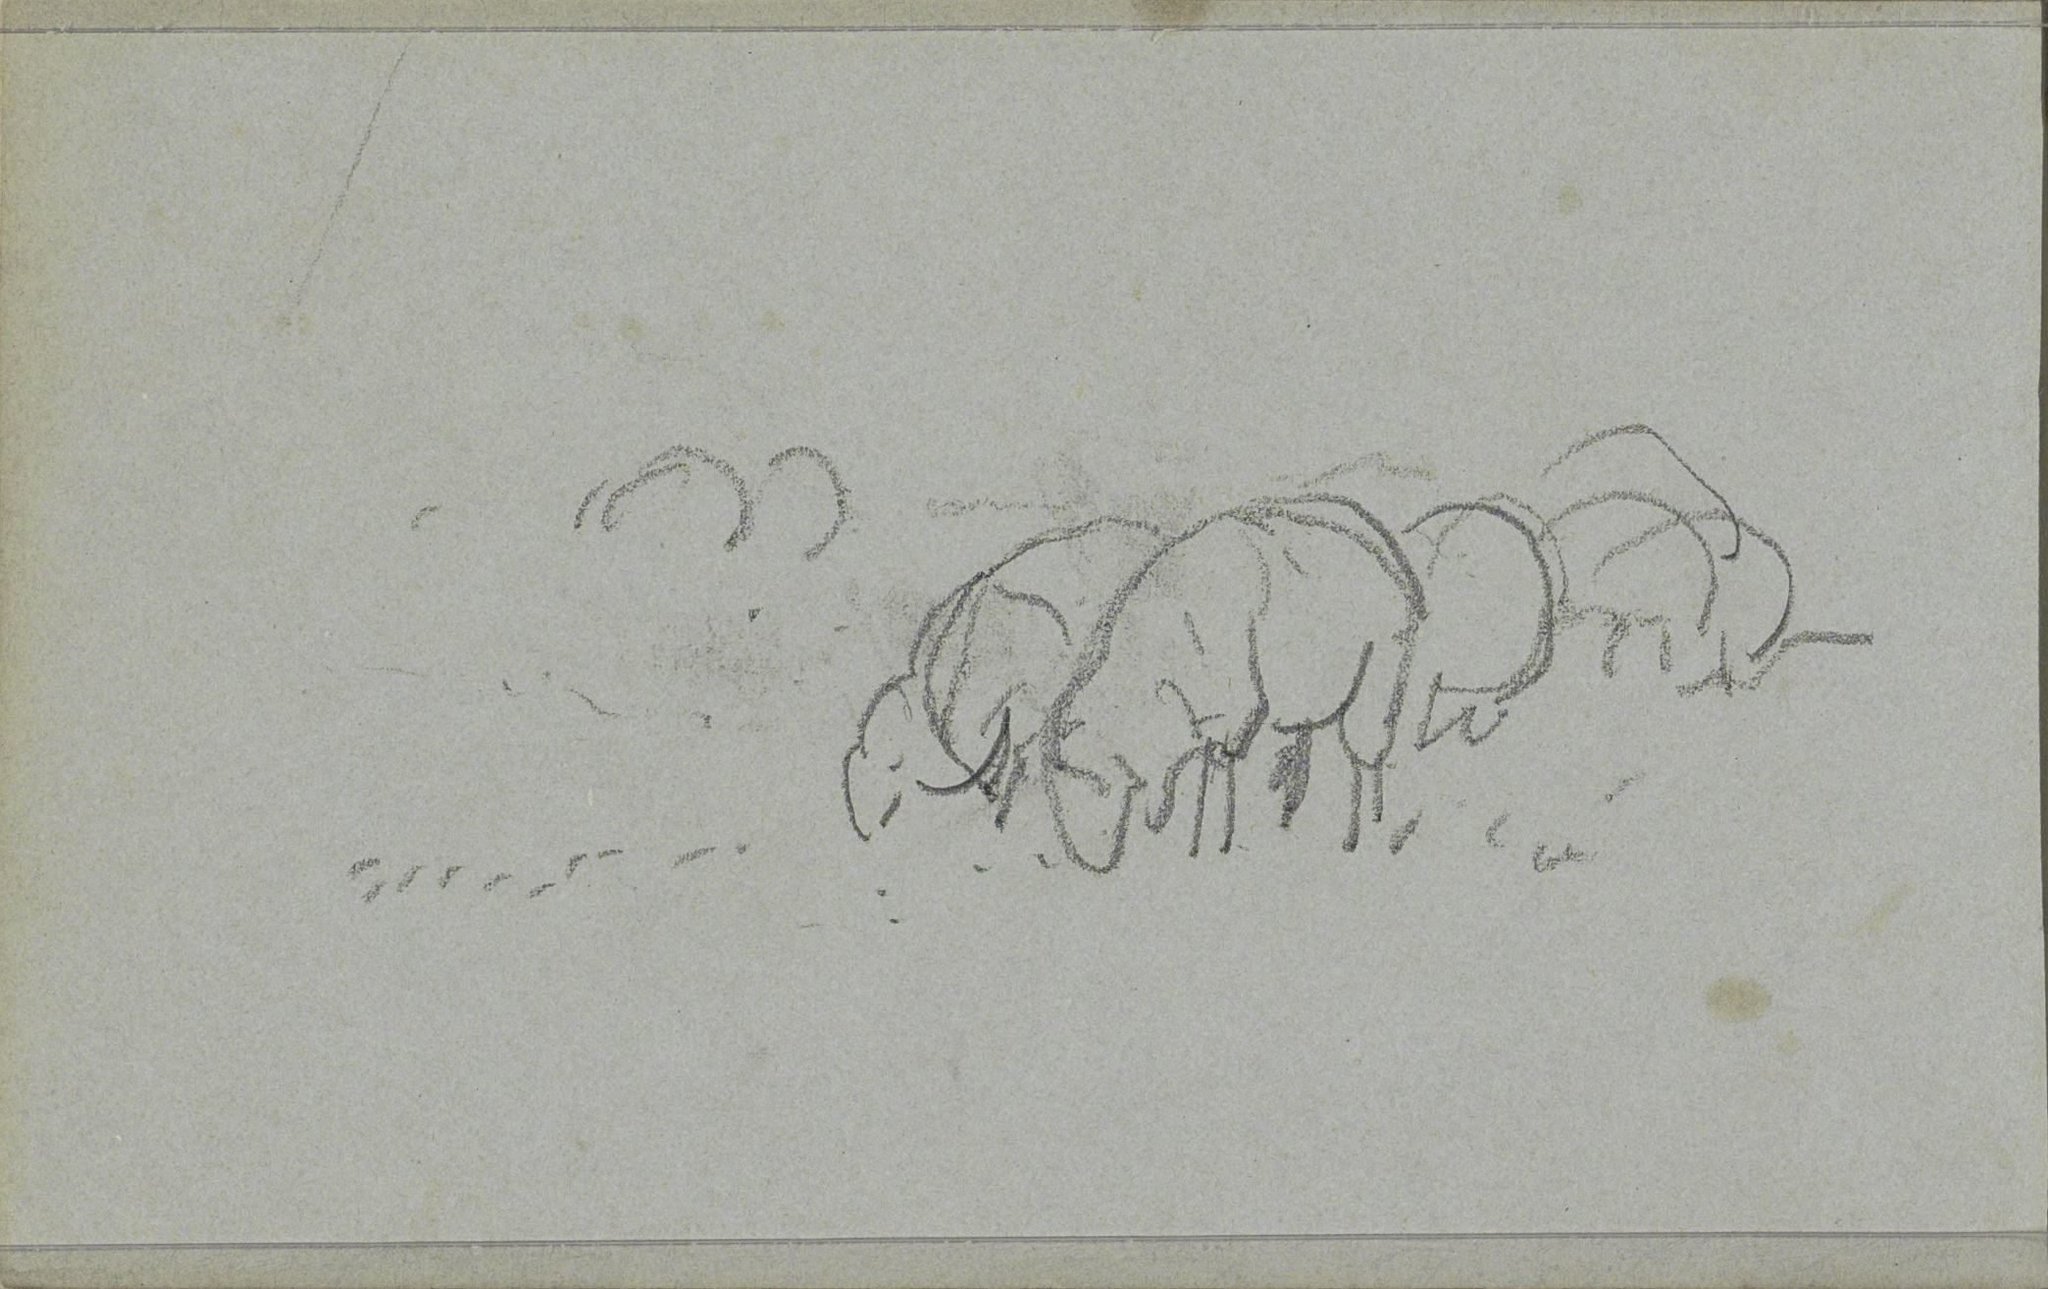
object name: sketchbook leaf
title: Grazende schapen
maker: anton mauve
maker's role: draughtsman, painter, print maker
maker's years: 1838-1888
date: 1848-1888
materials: paper, pencil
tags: sheep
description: Blad 34 verso uit een schetsboek met 44 bladen.